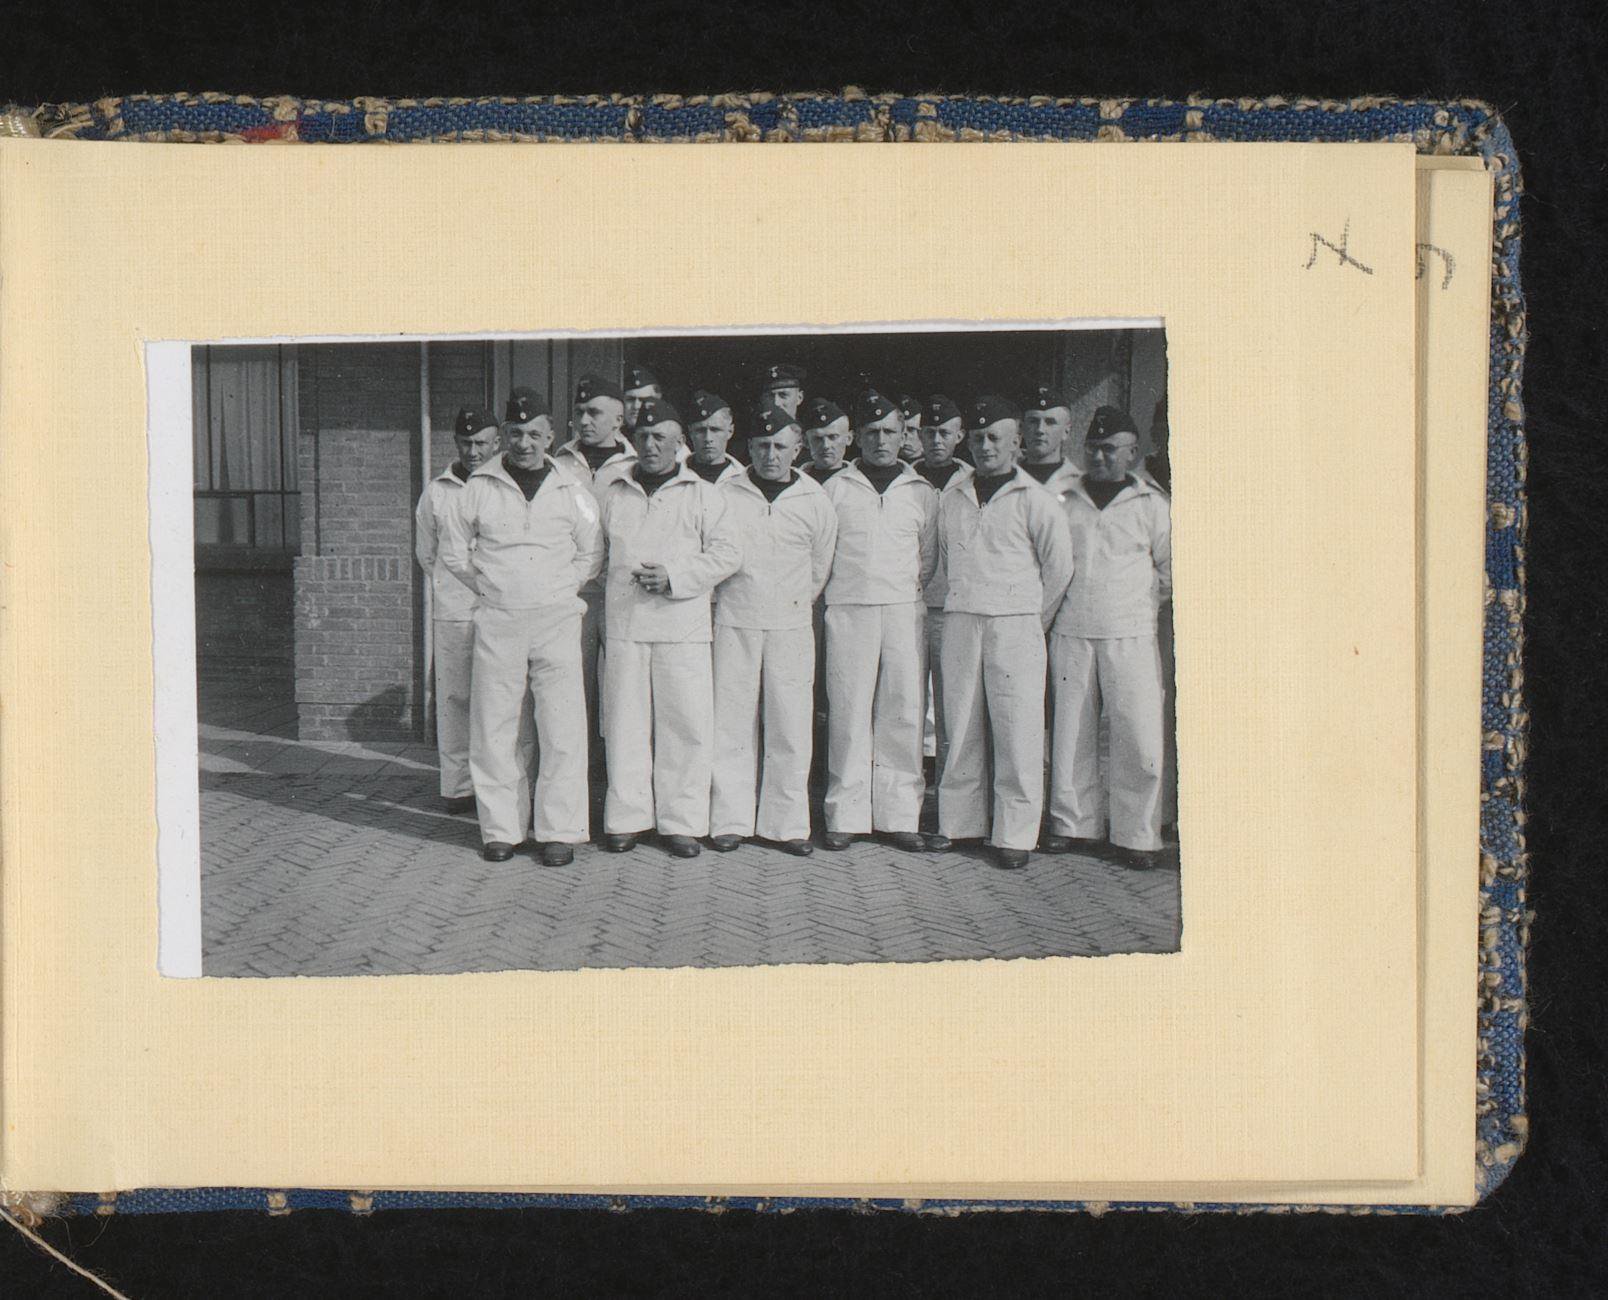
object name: photograph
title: Groepsfoto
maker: Anonymous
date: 1940-1943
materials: photographic support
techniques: gelatin silver print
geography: netherlands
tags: the company, the unit, the troop ~ military service, sailor, netherlands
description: Groepsfoto van een eenheid Duitse matrozen in wit uniform, staand voor een gebouw, in Nederland. Onderdeel van het fotoalbum over de Kriegsmarine 1940-1943.